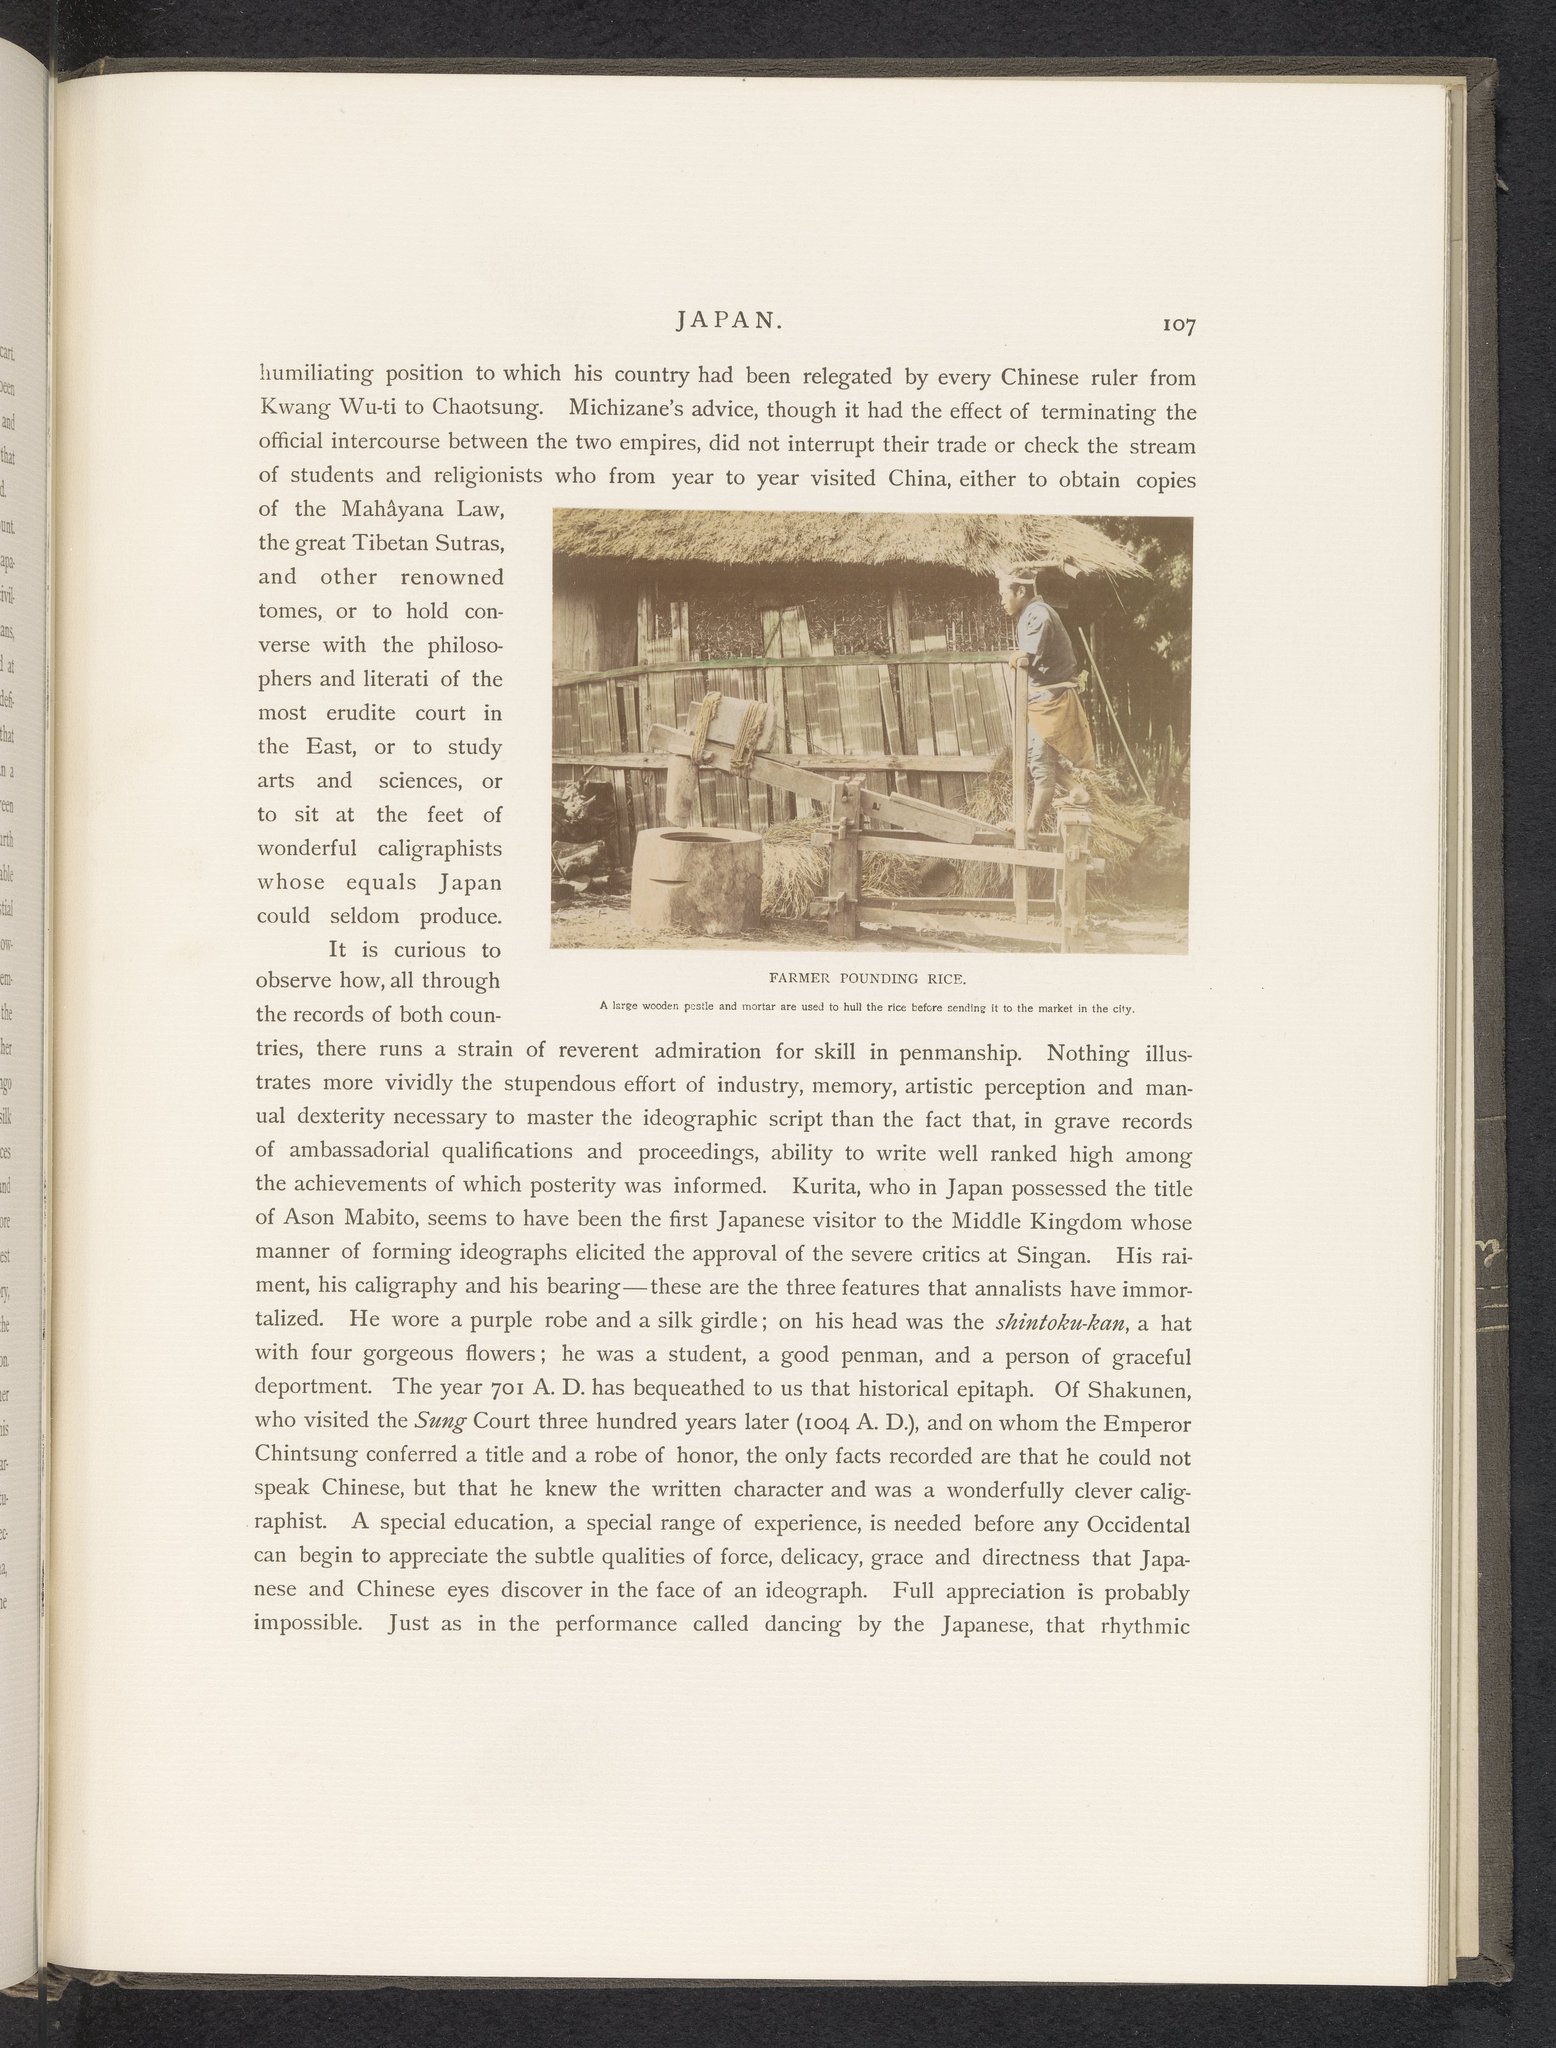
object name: page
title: Farmer pounding rice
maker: Anonymous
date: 1887-1897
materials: photographic support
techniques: albumen print, hand coloring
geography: japan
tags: farmers, agricultural implements, cereal, grain, corn (grass with grains, grown for food, e.g.: wheat, rice, rye, oats, maize, buckwheat, millet)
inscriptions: inscription: ‘A large wooden pestle and mortar are used to hull the rice before sending it to the market in the city.’